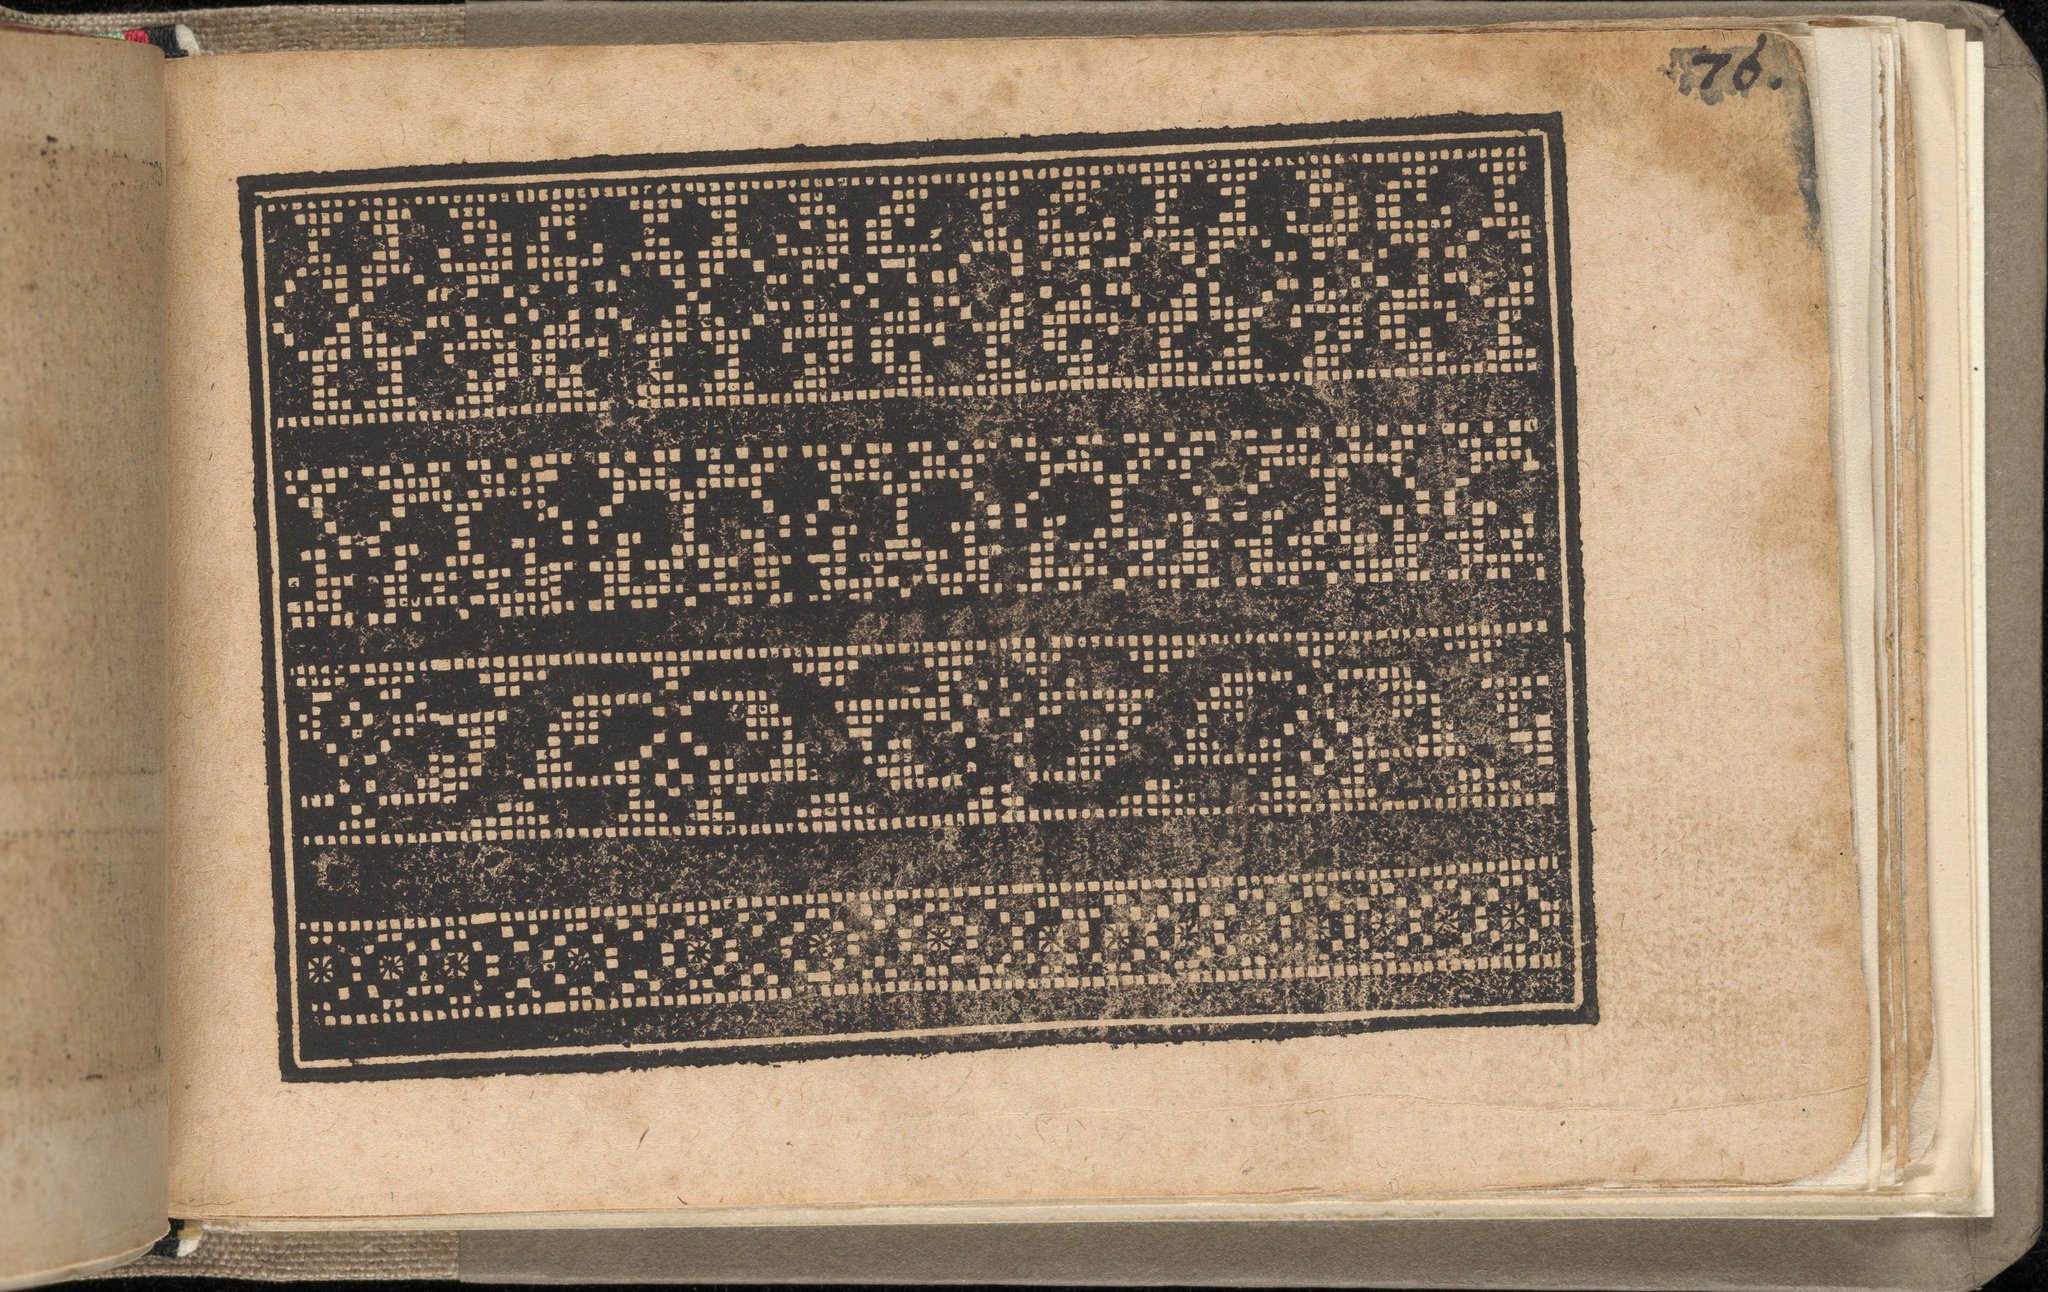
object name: book print ornament architecture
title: Schön newes Modelbuch (Page 76r)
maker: sigismundus latomus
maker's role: publisher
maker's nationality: german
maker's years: 1599-1632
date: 1608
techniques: woodcut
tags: ornament